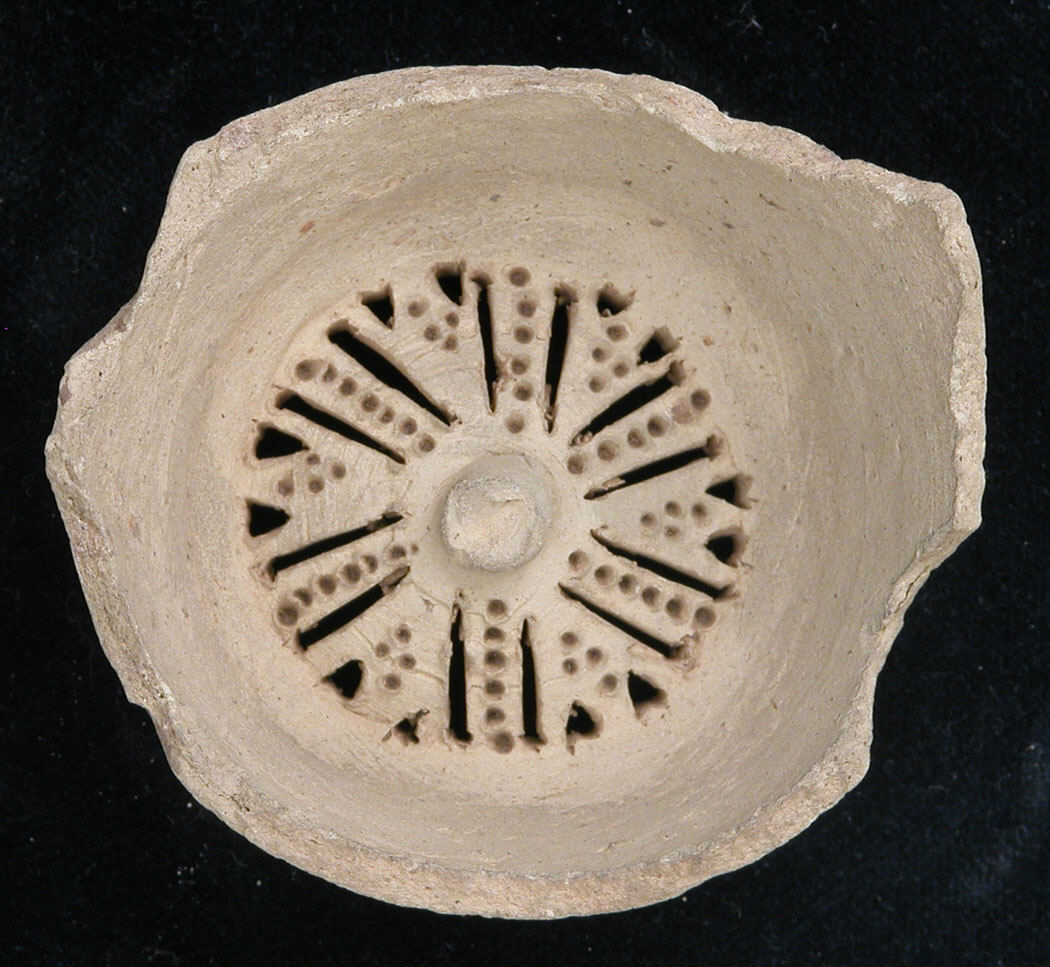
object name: water filter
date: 901-1200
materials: earthenware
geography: egypt